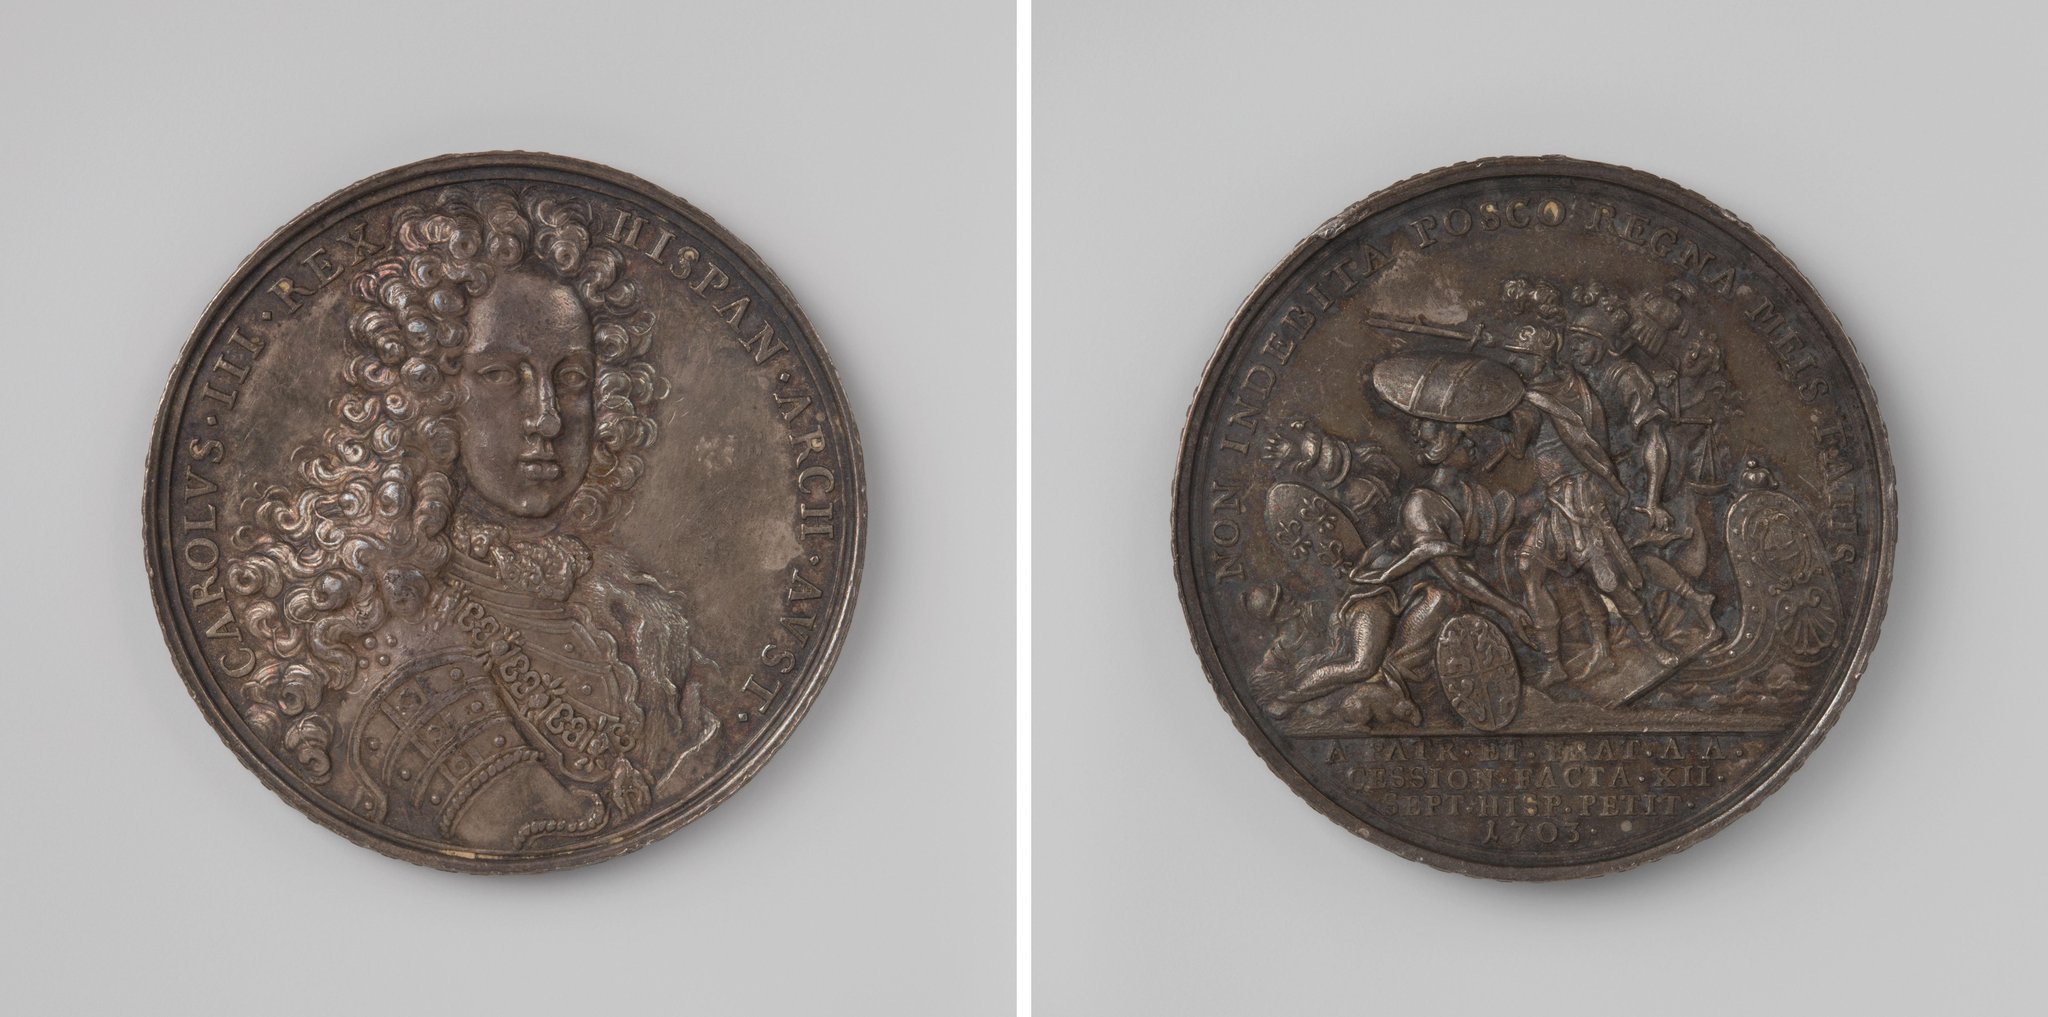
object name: history medal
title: Vertrek van Karel III uit Wenen om bezit te nemen van de Spaanse troon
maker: georg hautsch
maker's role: medailleur, muntmaker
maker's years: 1679-1745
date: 1703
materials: silver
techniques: striking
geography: nuremberg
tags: vienna, charles vi (holy roman emperor), spain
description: Zilveren penning. Voorzijde: borststuk man binnen omschrift. Keerzijde: Karel, afgebeeld als Romeinse held, vergezeld door Kracht en Gerechtigheid verdedigt Spanje, in gedaante van smekende vrouw tegen Franse krijgsknechten binnen omschrift, boven opschrift; randschrift